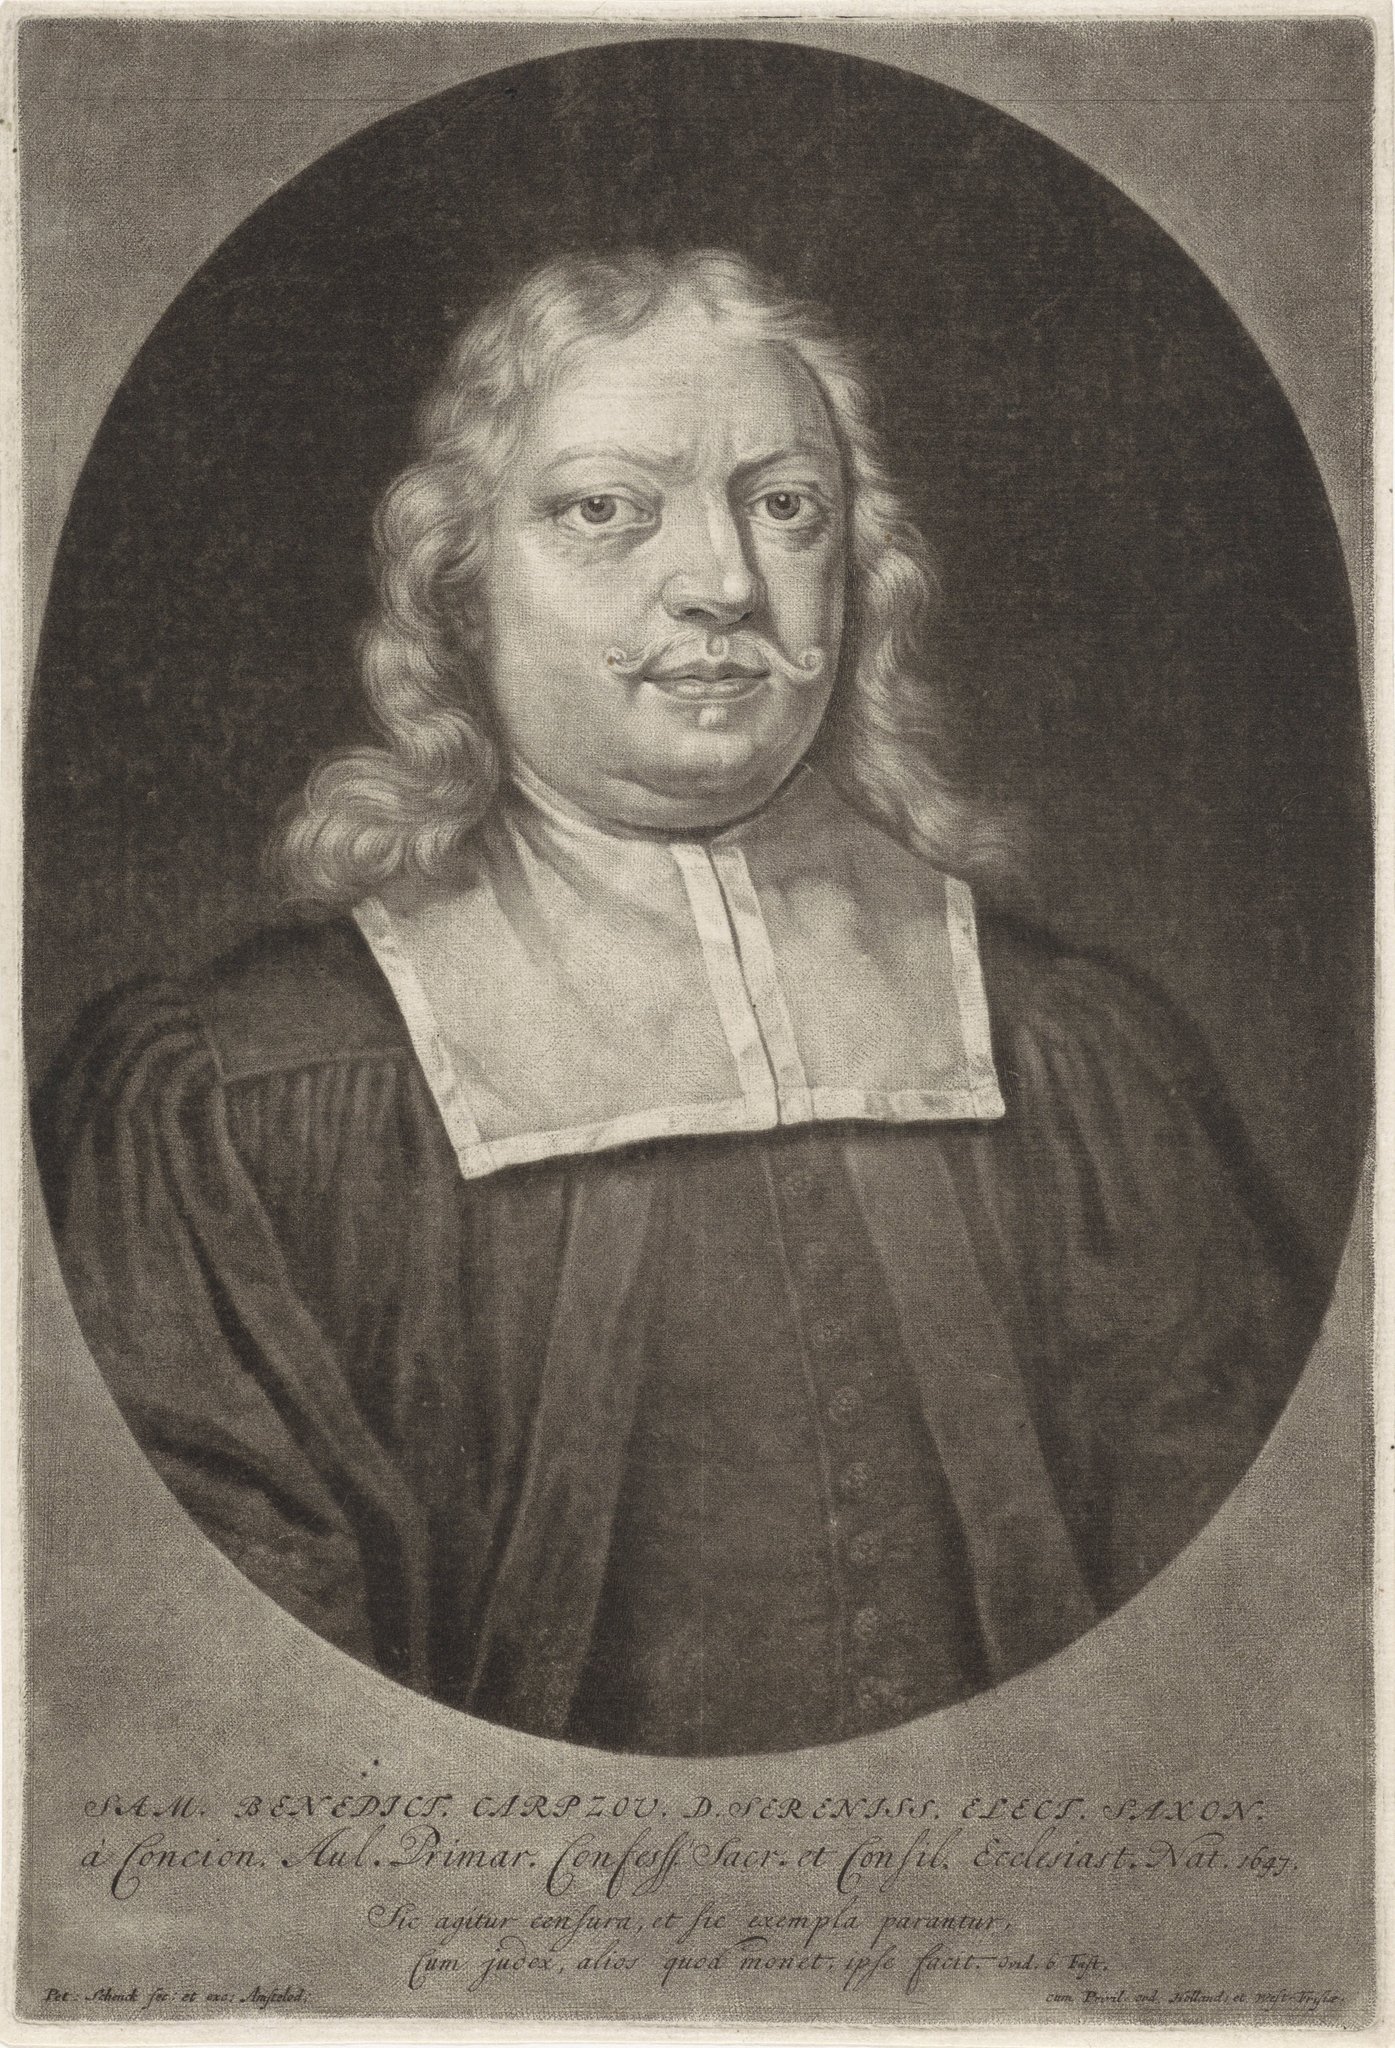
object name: print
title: Portret van de theoloog Samuel Benedikt Carpzov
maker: pieter schenk (i)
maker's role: print maker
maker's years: 1660-1711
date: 1670-1713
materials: paper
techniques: engraving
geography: amsterdam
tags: samuel benedikt carpzov, theologian, moustache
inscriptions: collector's mark: Lugt 2228